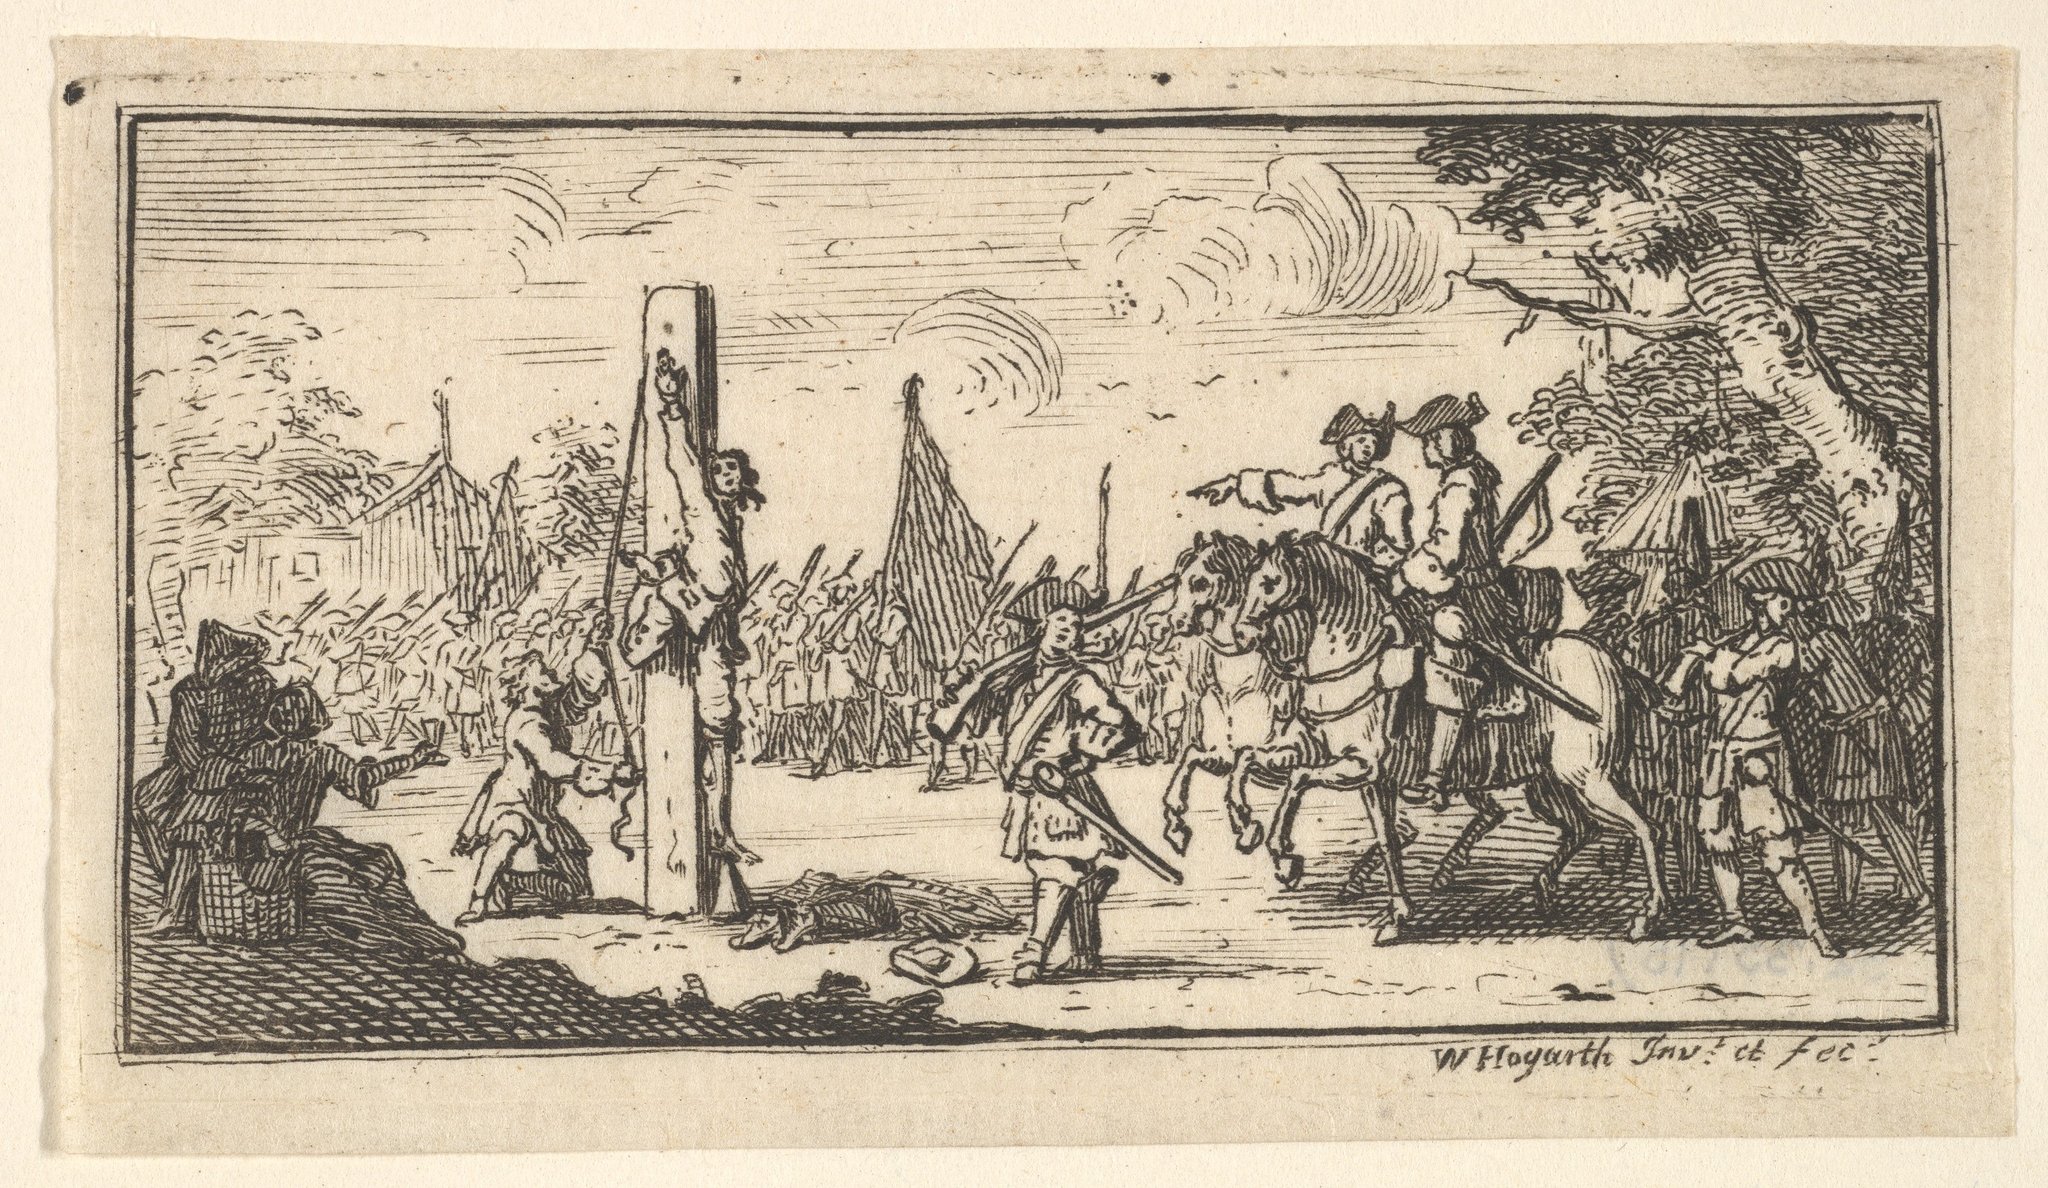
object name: print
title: Hanging by the Thumbs (Modern Military Punishments)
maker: william hogarth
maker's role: artist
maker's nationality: british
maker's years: 1697-1764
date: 1725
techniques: etching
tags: military,men,horses,punishment